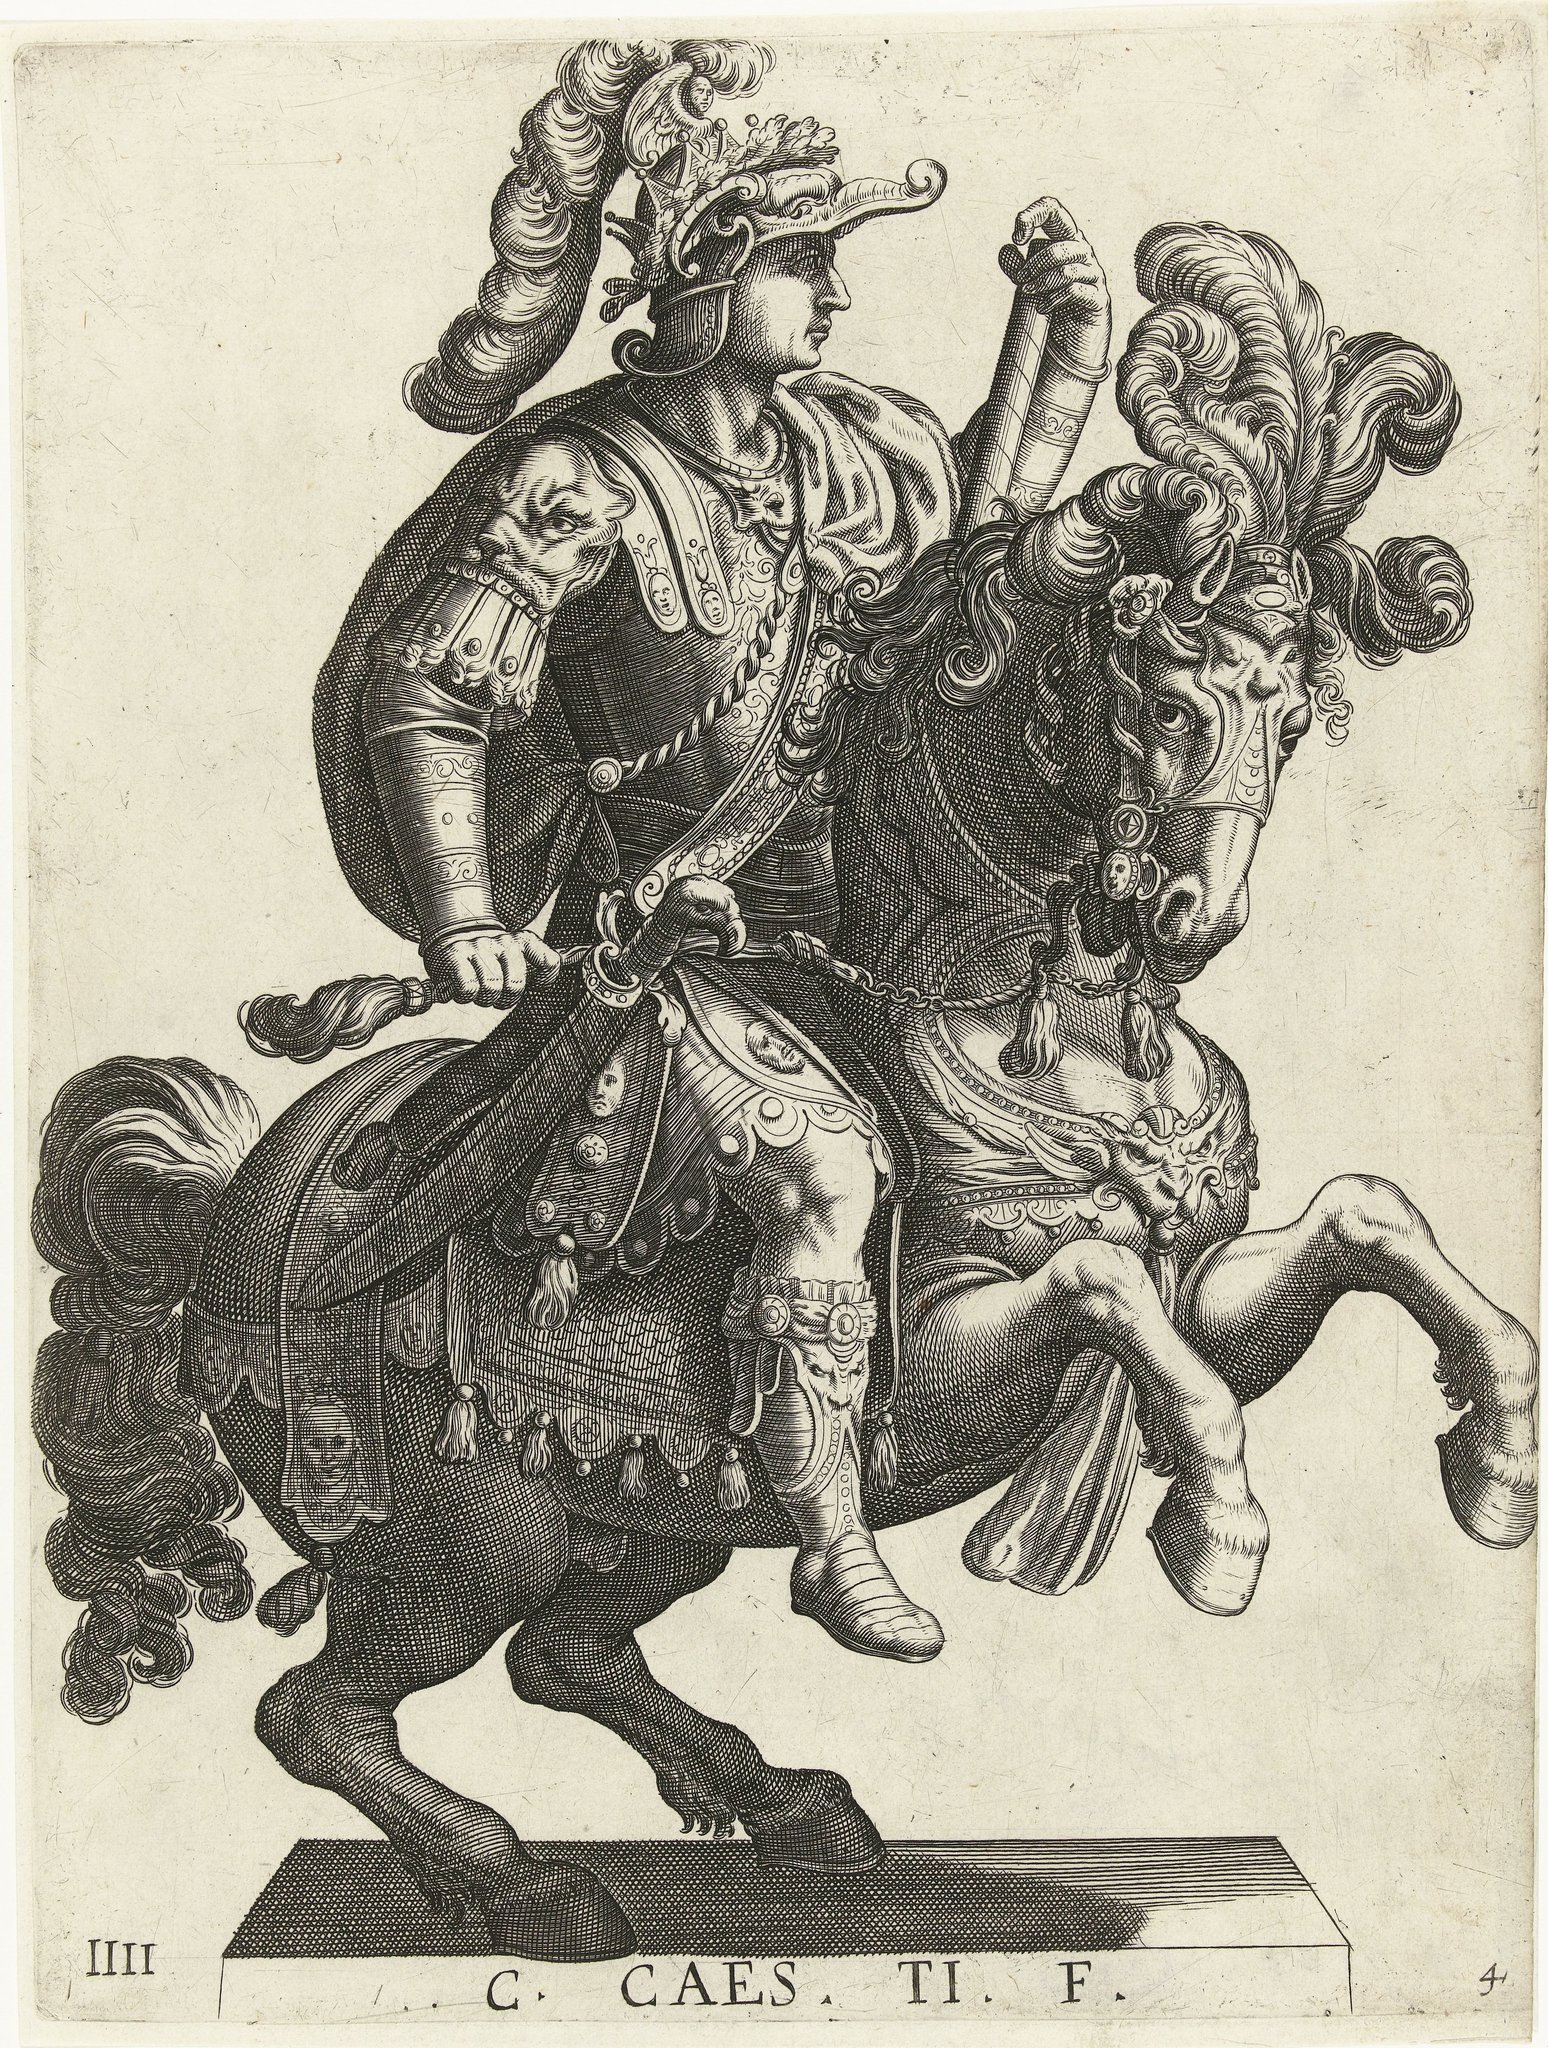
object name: print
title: Ruiterportret van een Romeins keizer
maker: laurens eillarts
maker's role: print maker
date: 1616-1620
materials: paper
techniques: engraving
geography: rome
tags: emperor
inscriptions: collector's mark: Lugt 2228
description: Een Romeins keizer te paard, en profil afgebeeld met één hand aan de teugel en in de andere zijn commandostaf.